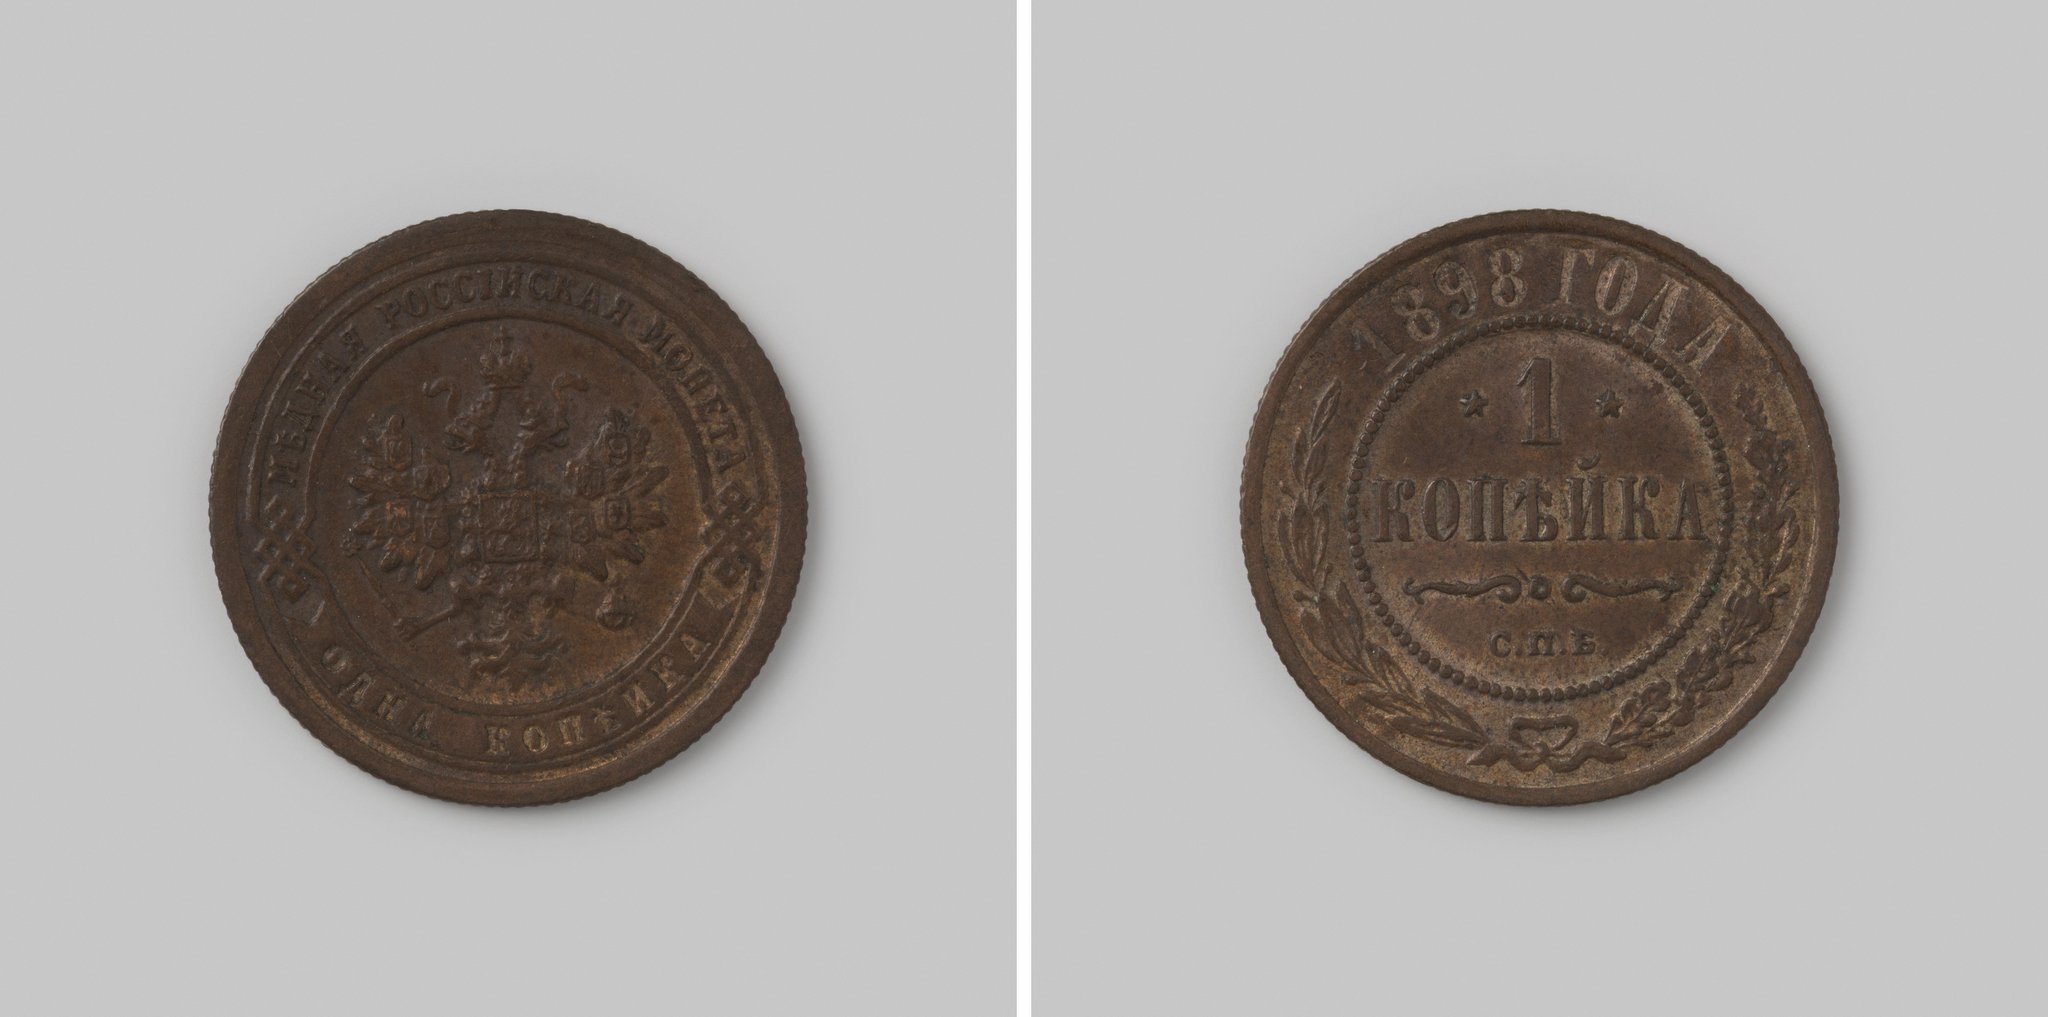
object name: coin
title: Rusland, tsaar Nicholai II, kopek,1898 SPB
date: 1898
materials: copper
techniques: striking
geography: sint-petersburg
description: Koperen munt. Voorzijde: dubbelkoppige gekroonde adelaar met gespreide vleugels en met op zijn vleugels kleine wapenschilden en op zijn borst een groot, met een ridderorde omhangen wapenschild en in zijn poten een scepter en een gekroonde bol. Boven de adelaar een kroon met lint. Waarde-aanduiding in omschrift onderaan. Keerzijde: tussen twee samengebonden takken in twee regels waarde-aanduiding. Daaronder in het Cyrillisch de letters S,P en B [=Sint Petersburg]. Jaartal bovenaan in omschrift. Kartelrand.